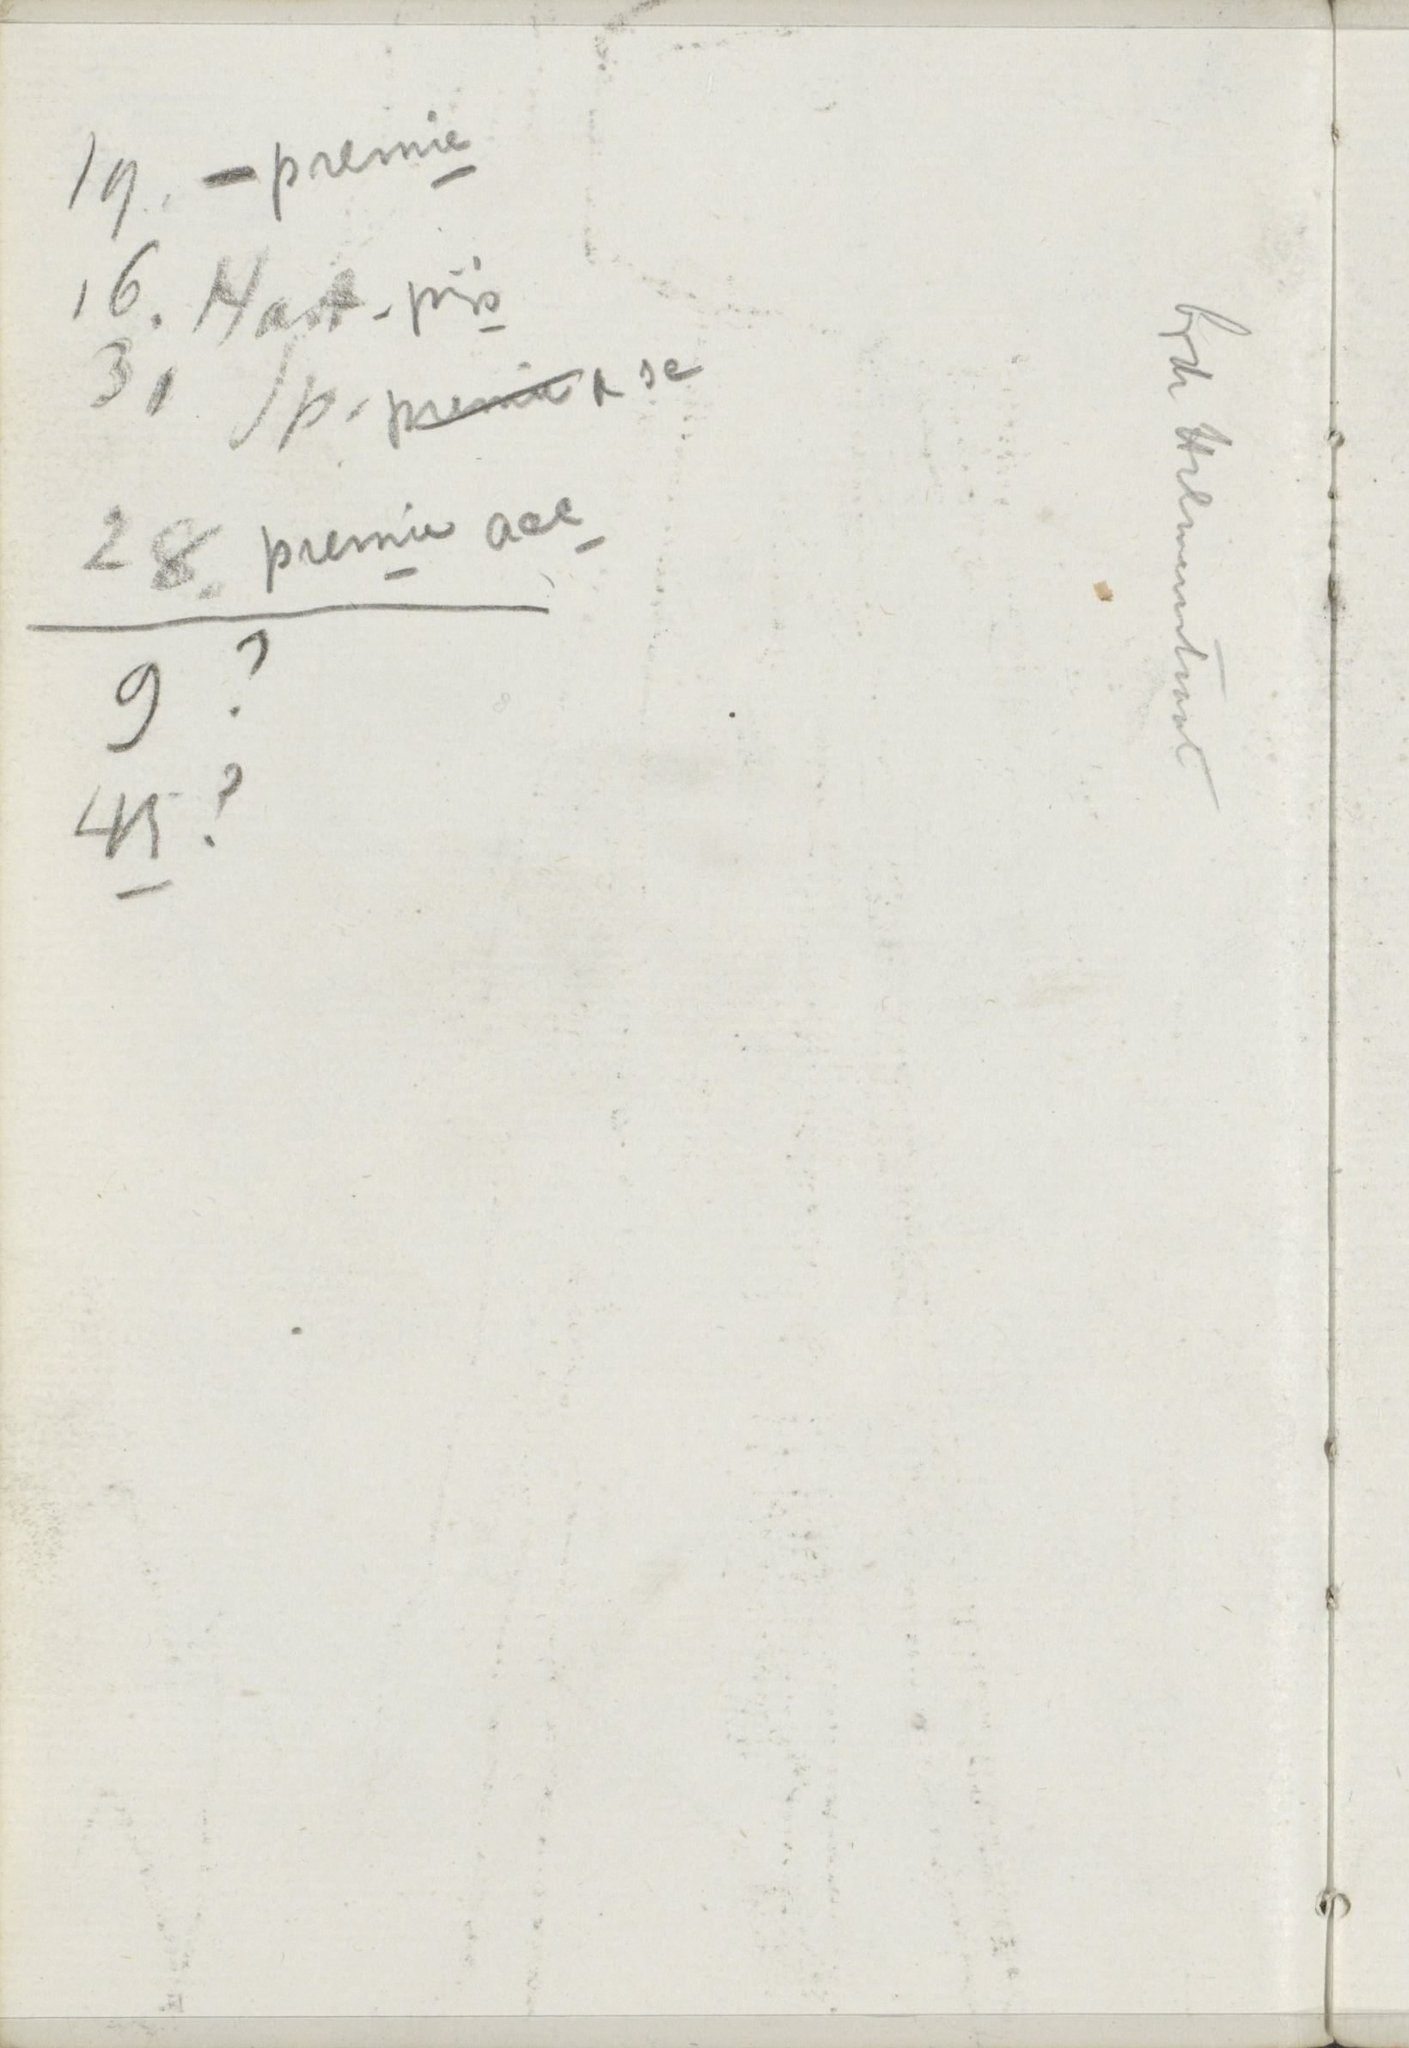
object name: sketchbook leaf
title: Annotaties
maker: george hendrik breitner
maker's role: draughtsman, painter, print maker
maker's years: 1857-1923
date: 1891-1894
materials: chalk, paper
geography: amsterdam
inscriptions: annotation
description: Pagina 23 uit een schetsboek met 15 bladen.